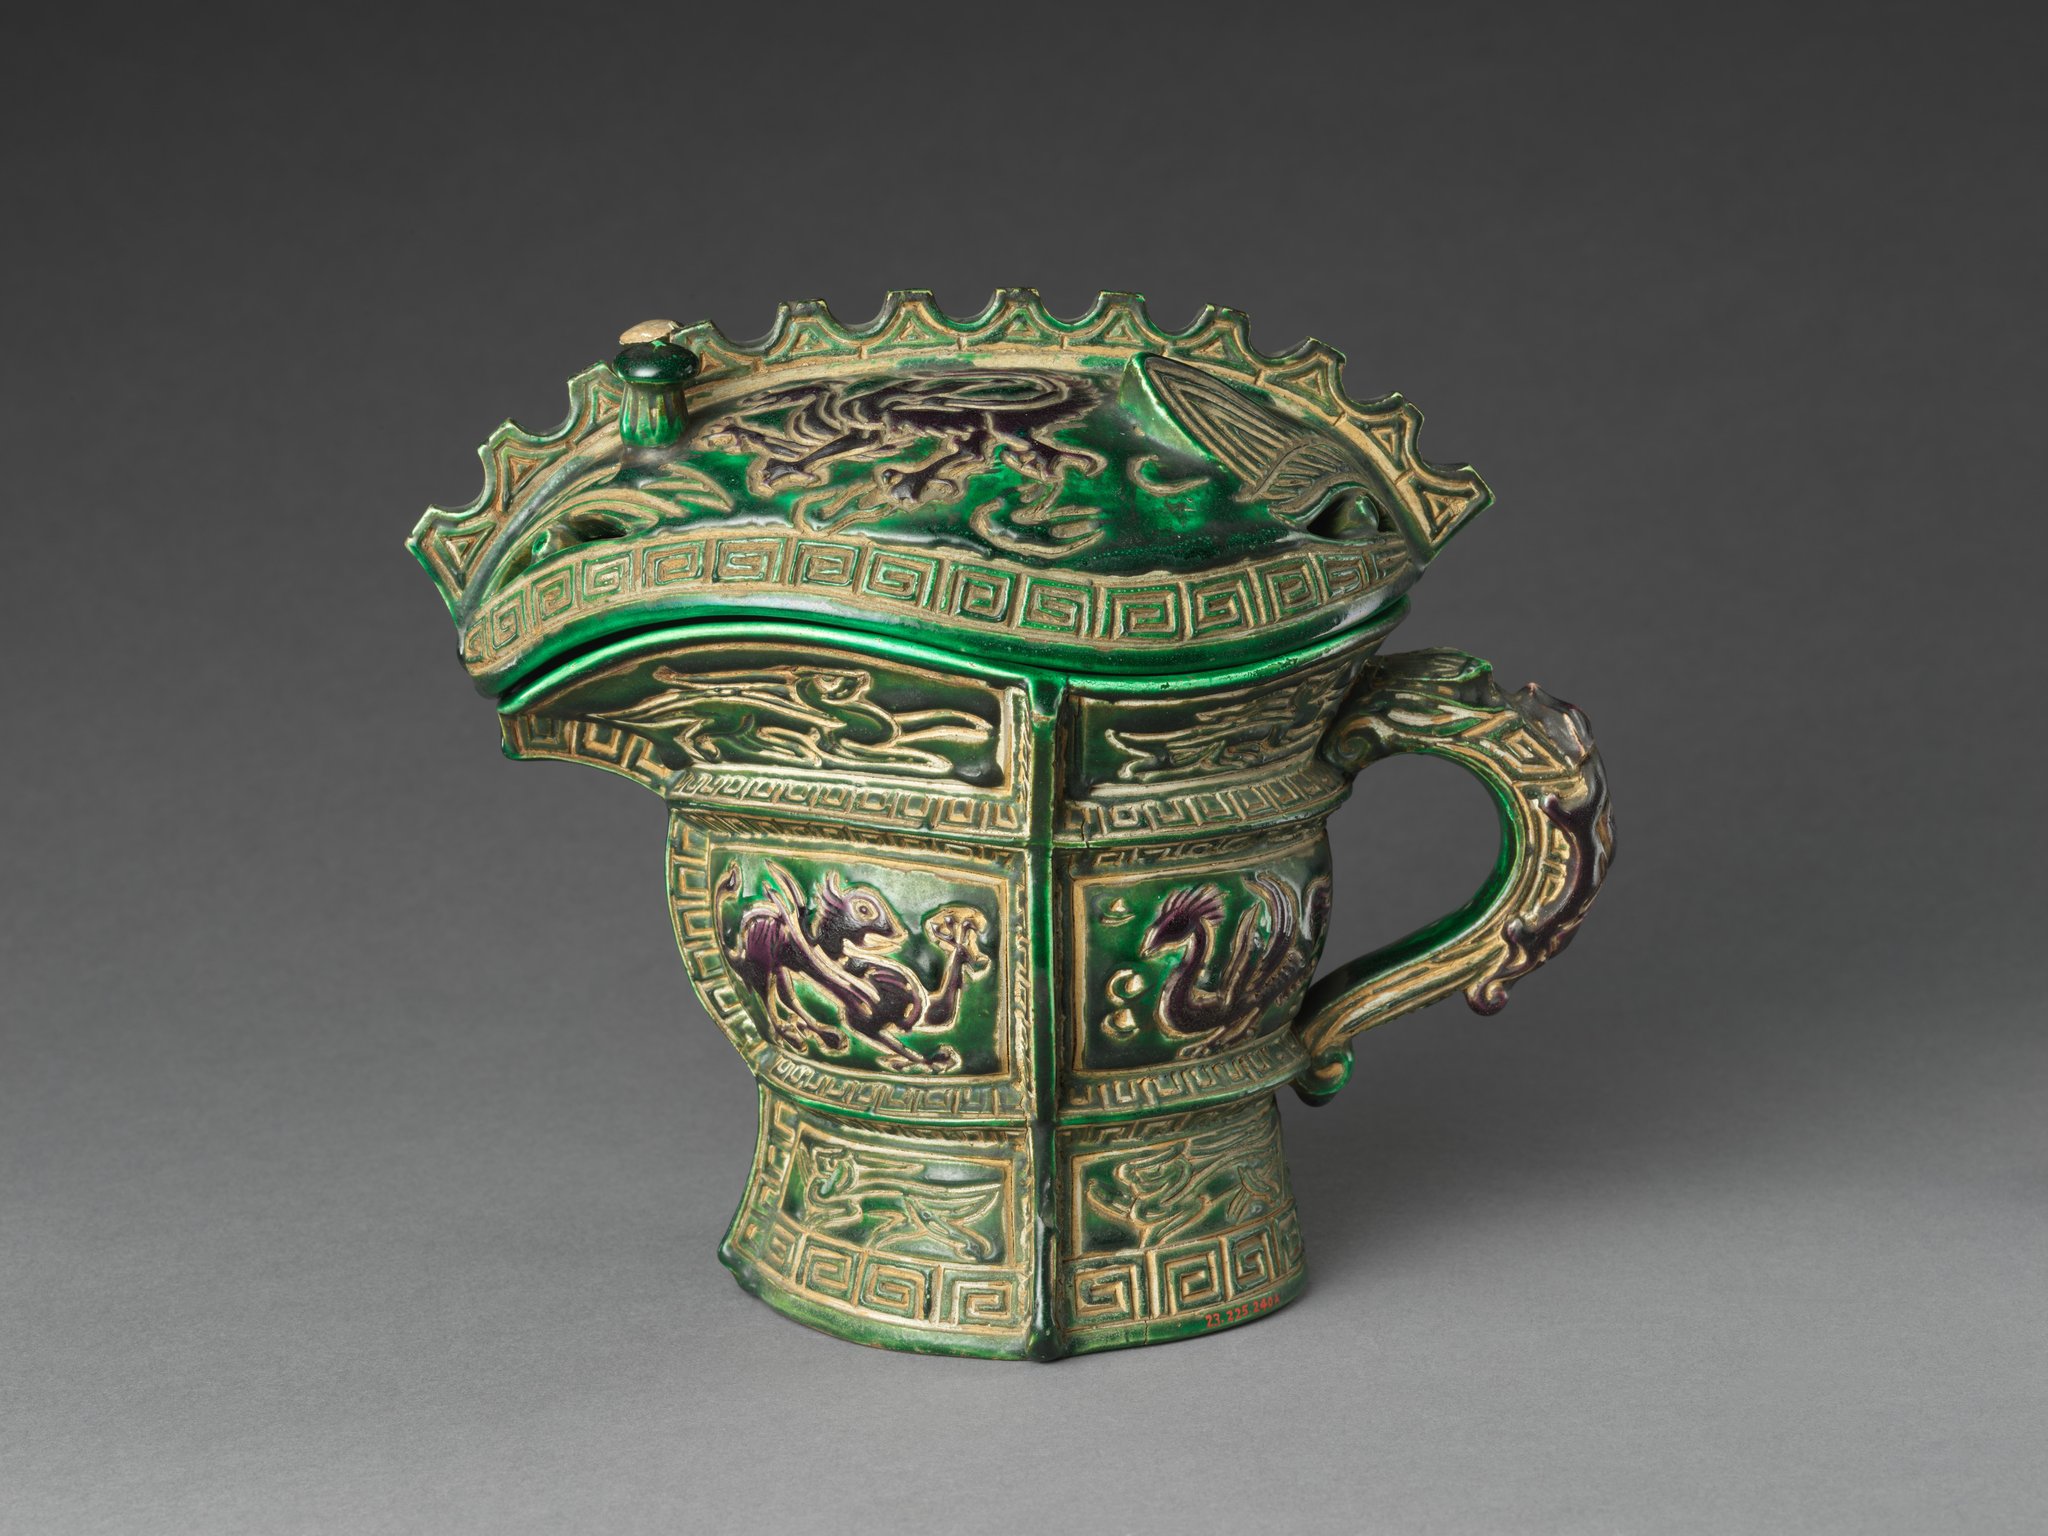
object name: covered censer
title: Rhinoceros-Shaped Incense Burner in the Cochin (Kōchi) Style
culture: japanese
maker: okuda eisen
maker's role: artist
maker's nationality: japanese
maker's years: 1753-1811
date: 1751-1800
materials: enamel, stoneware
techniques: overglaze, polychrome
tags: dragons,phoenix